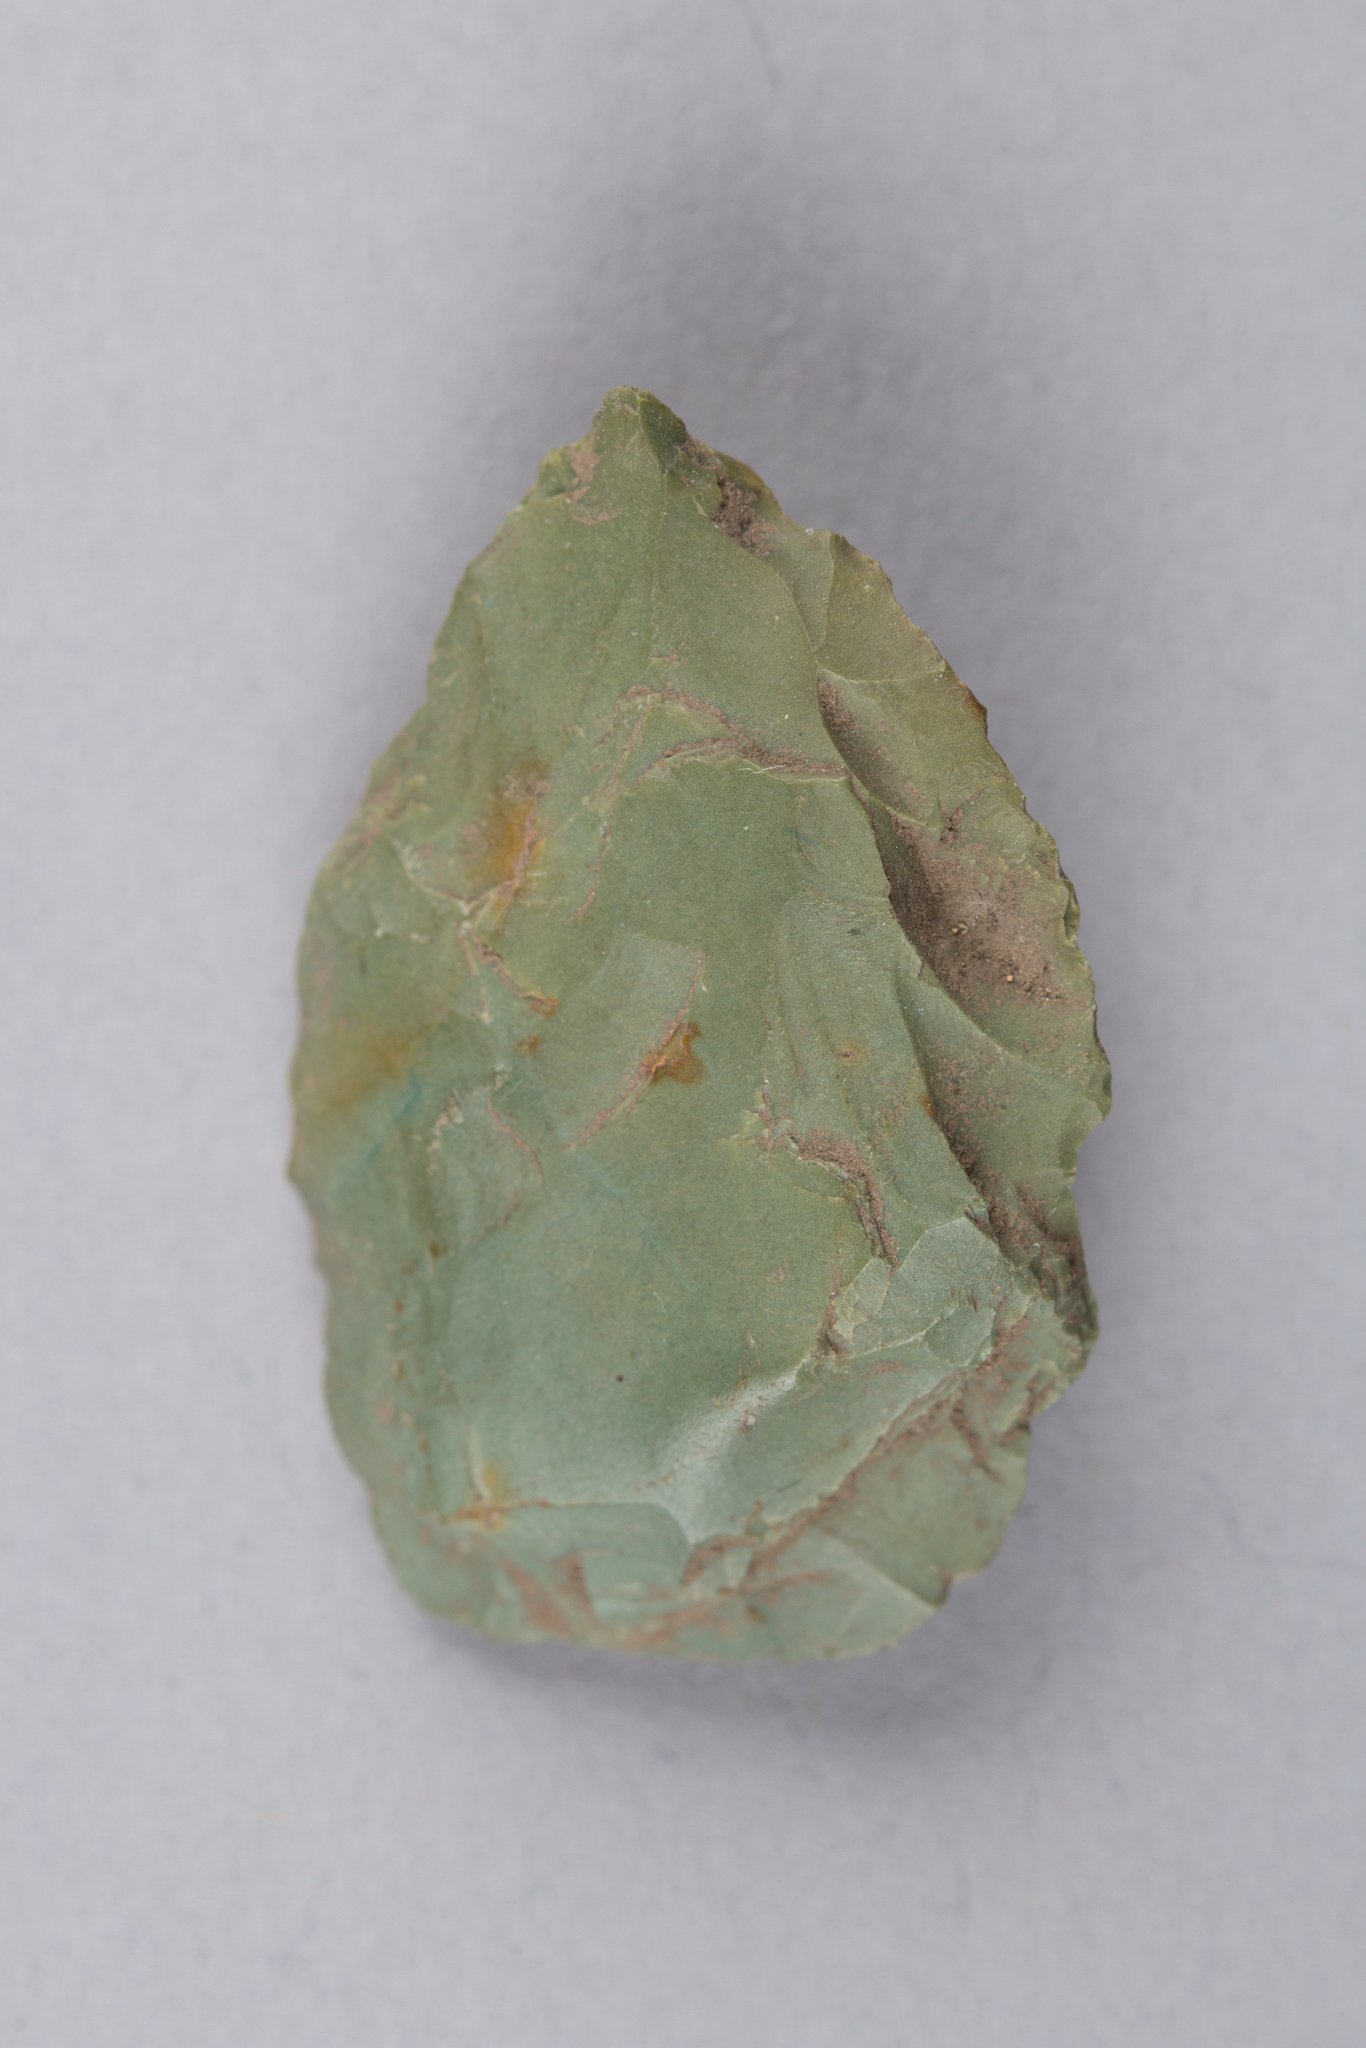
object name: arrowhead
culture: japanese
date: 1500-1000 BCE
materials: stone